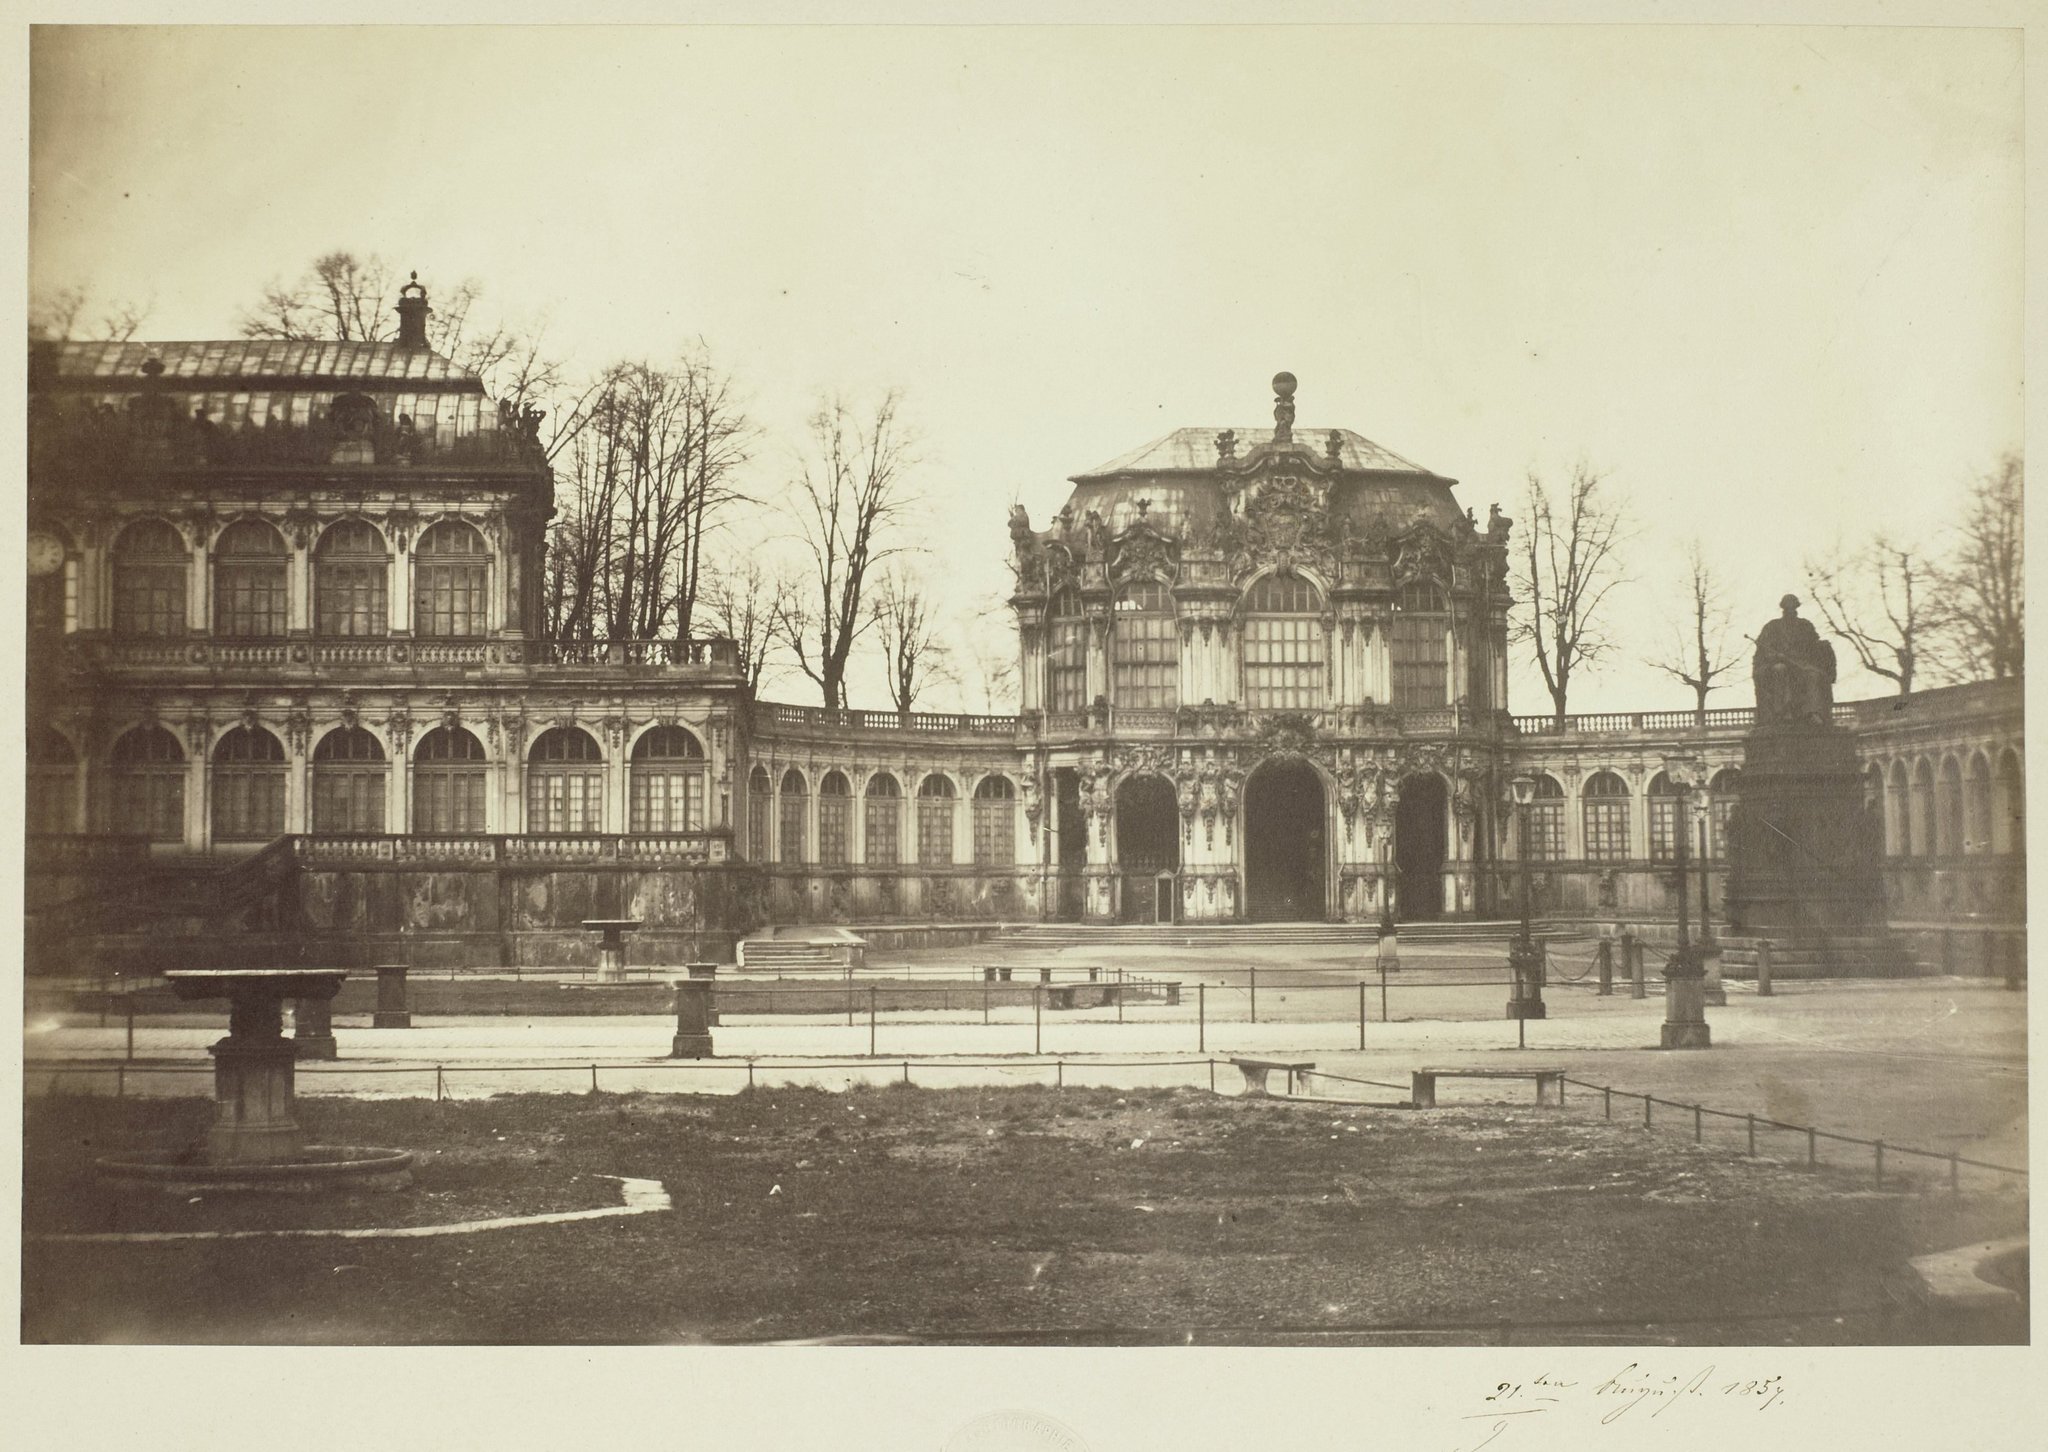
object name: photograph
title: Vleugel van de Zwinger in Dresden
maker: hermann krone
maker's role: fotograaf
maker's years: 1827-1916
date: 1857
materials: cardboard, photographic support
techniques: salted paper print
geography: dresden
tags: zwinger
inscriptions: date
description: Vleugel van de Zwinger in Dresden. Nummer 9 uit serie foto's van Dresden